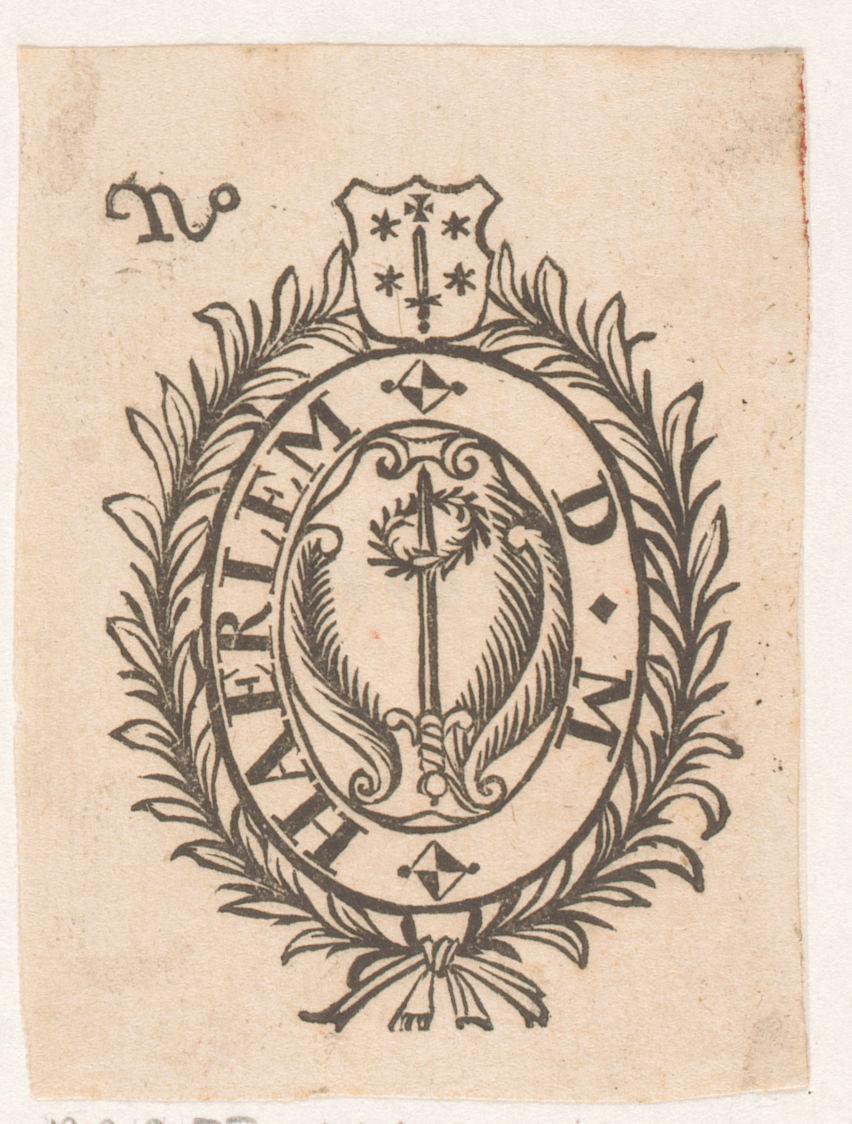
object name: print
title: Vignet met een zwaard met een lauwerkrans en het wapen van de stad Haarlem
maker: Anonymous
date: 1600-1699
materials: paper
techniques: woodcut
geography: netherlands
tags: coat of arms (as symbol of the state, etc.) (+ city; municipal), garland, wreath, hacking and thrusting weapons: sword, vignette, haarlem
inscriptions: collector's mark: Lugt 240